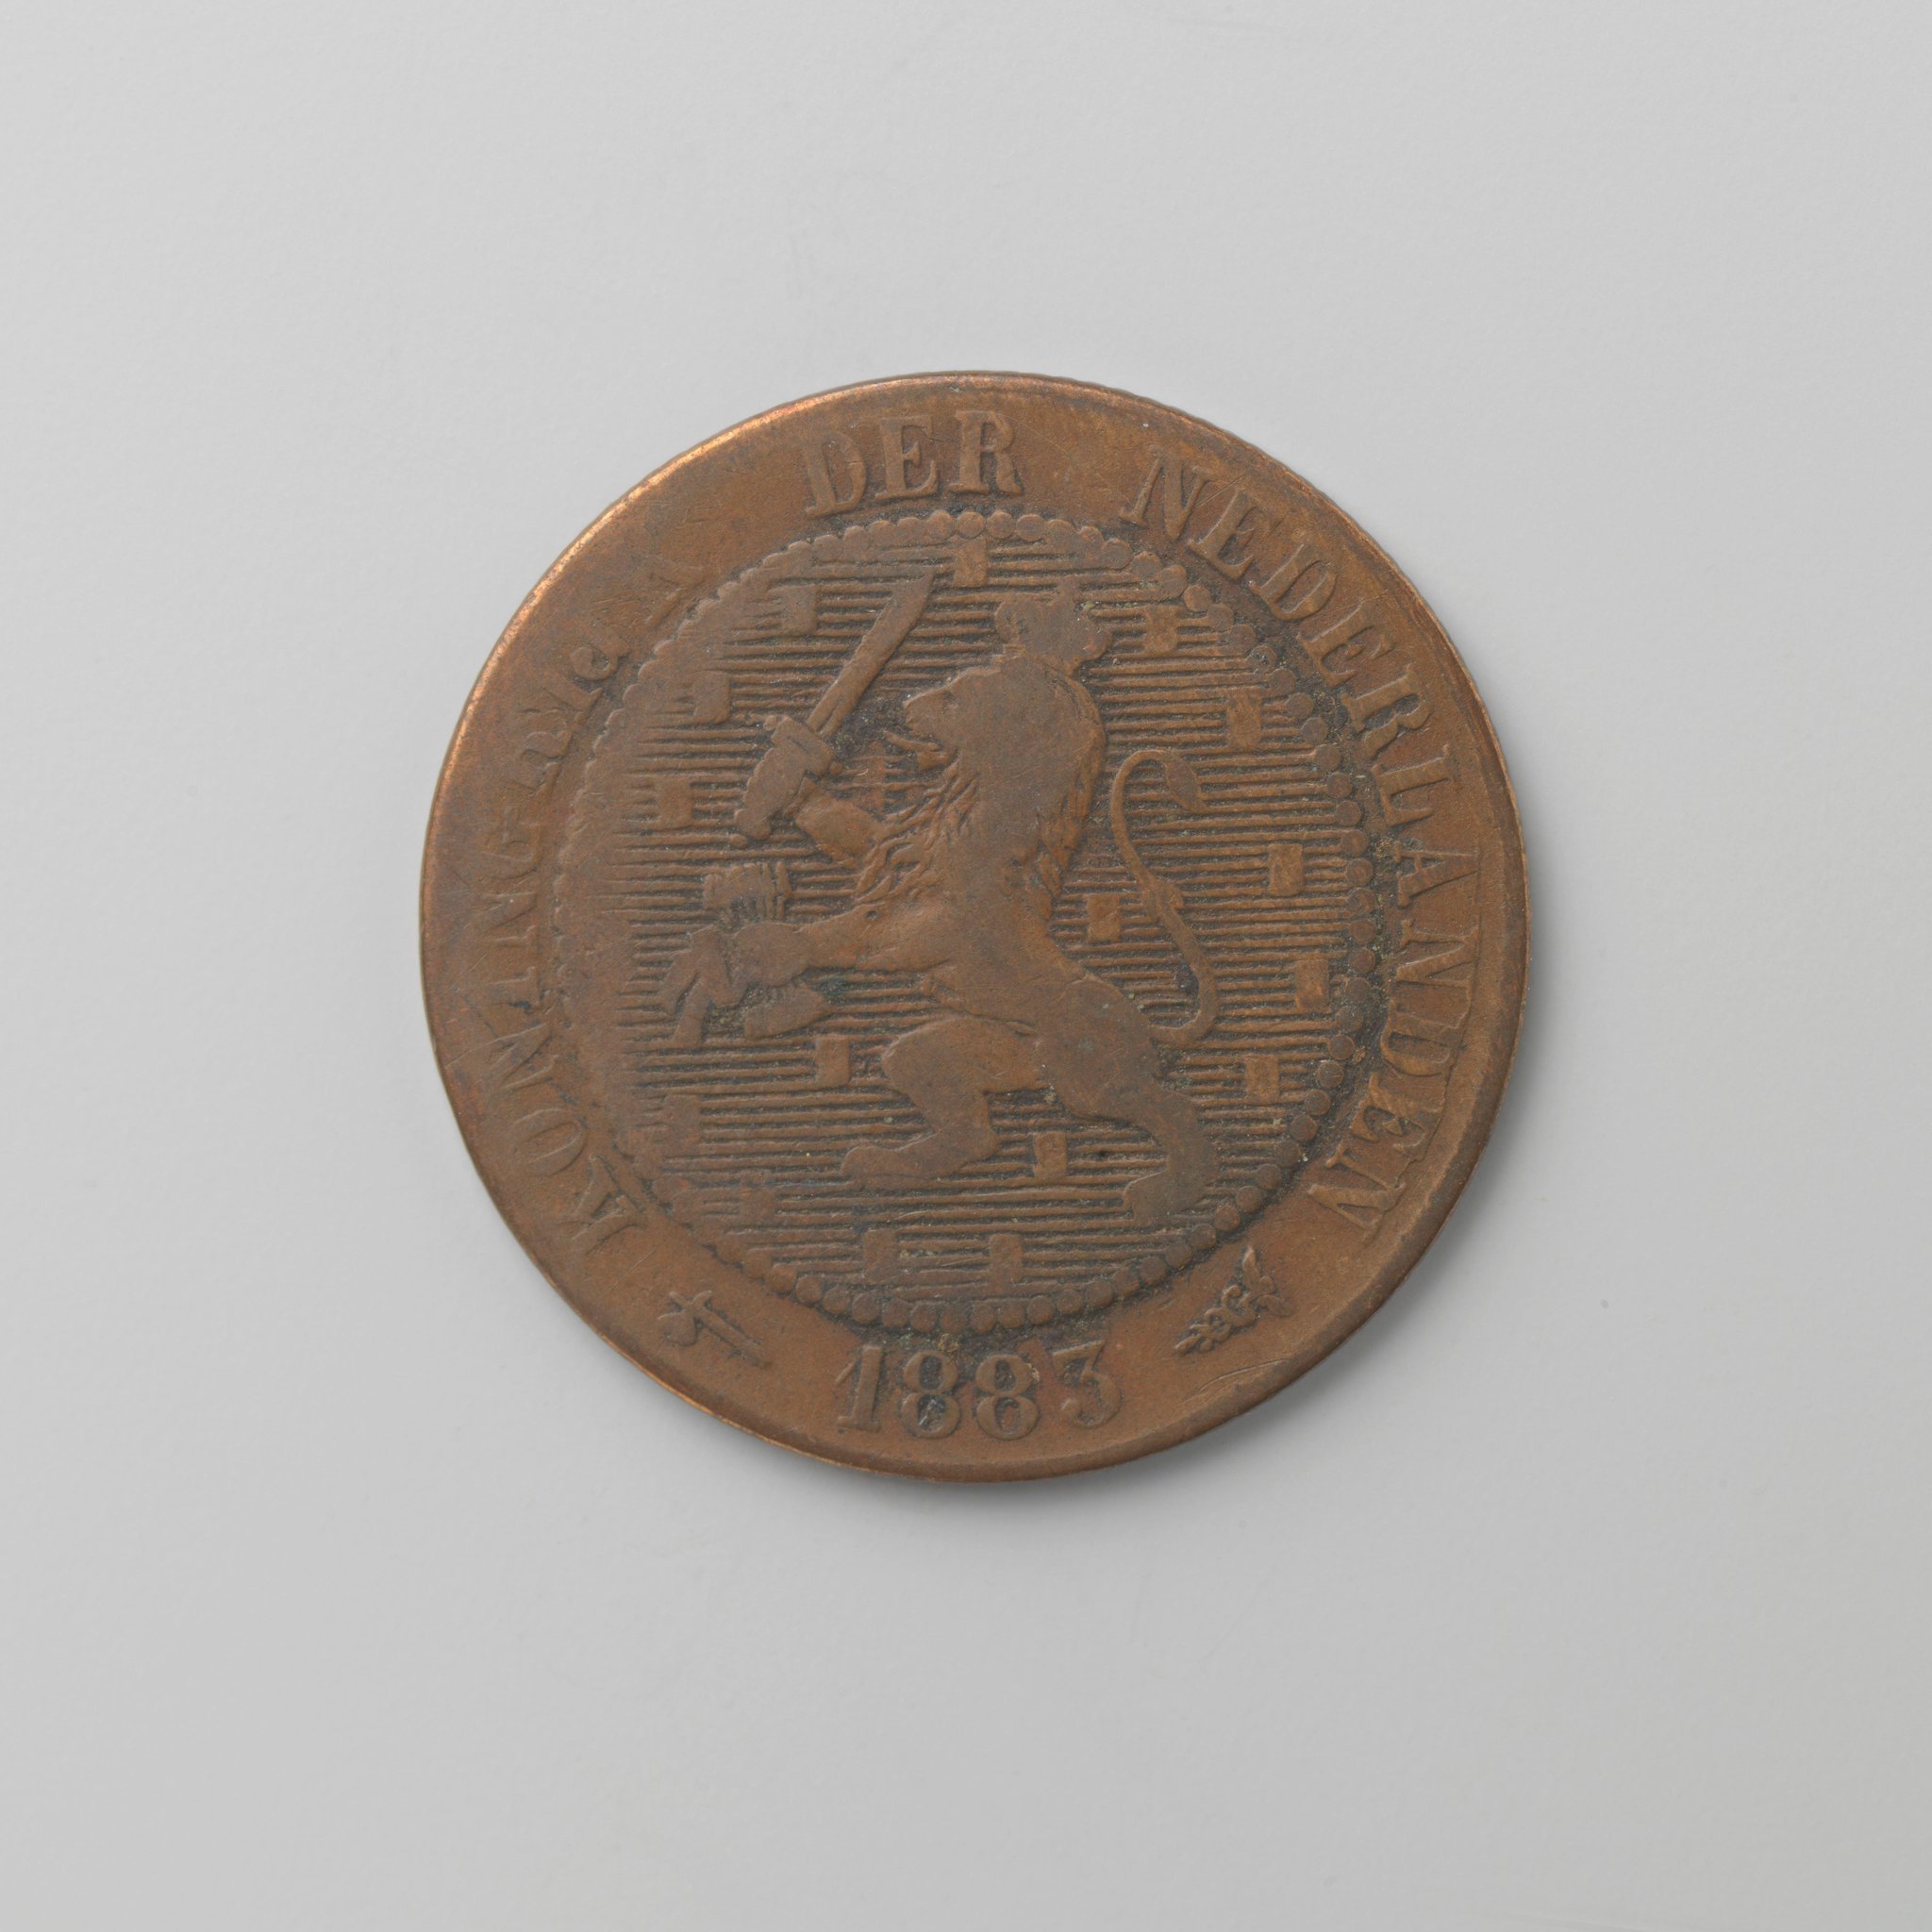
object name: coin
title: Nederlandse 2½ cent, 1883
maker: willem iii (koning der nederlanden)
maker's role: koning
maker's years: 1817-1890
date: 1883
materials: bronze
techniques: striking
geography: utrecht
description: Bronzen munt. Voorzijde: in een veld rijkswapen. Jaartal onderaan in omschrift. Keerzijde: binnen twee samengebonden oranjetakken waarde-aanduiding 2½ cent. Kartelrand.